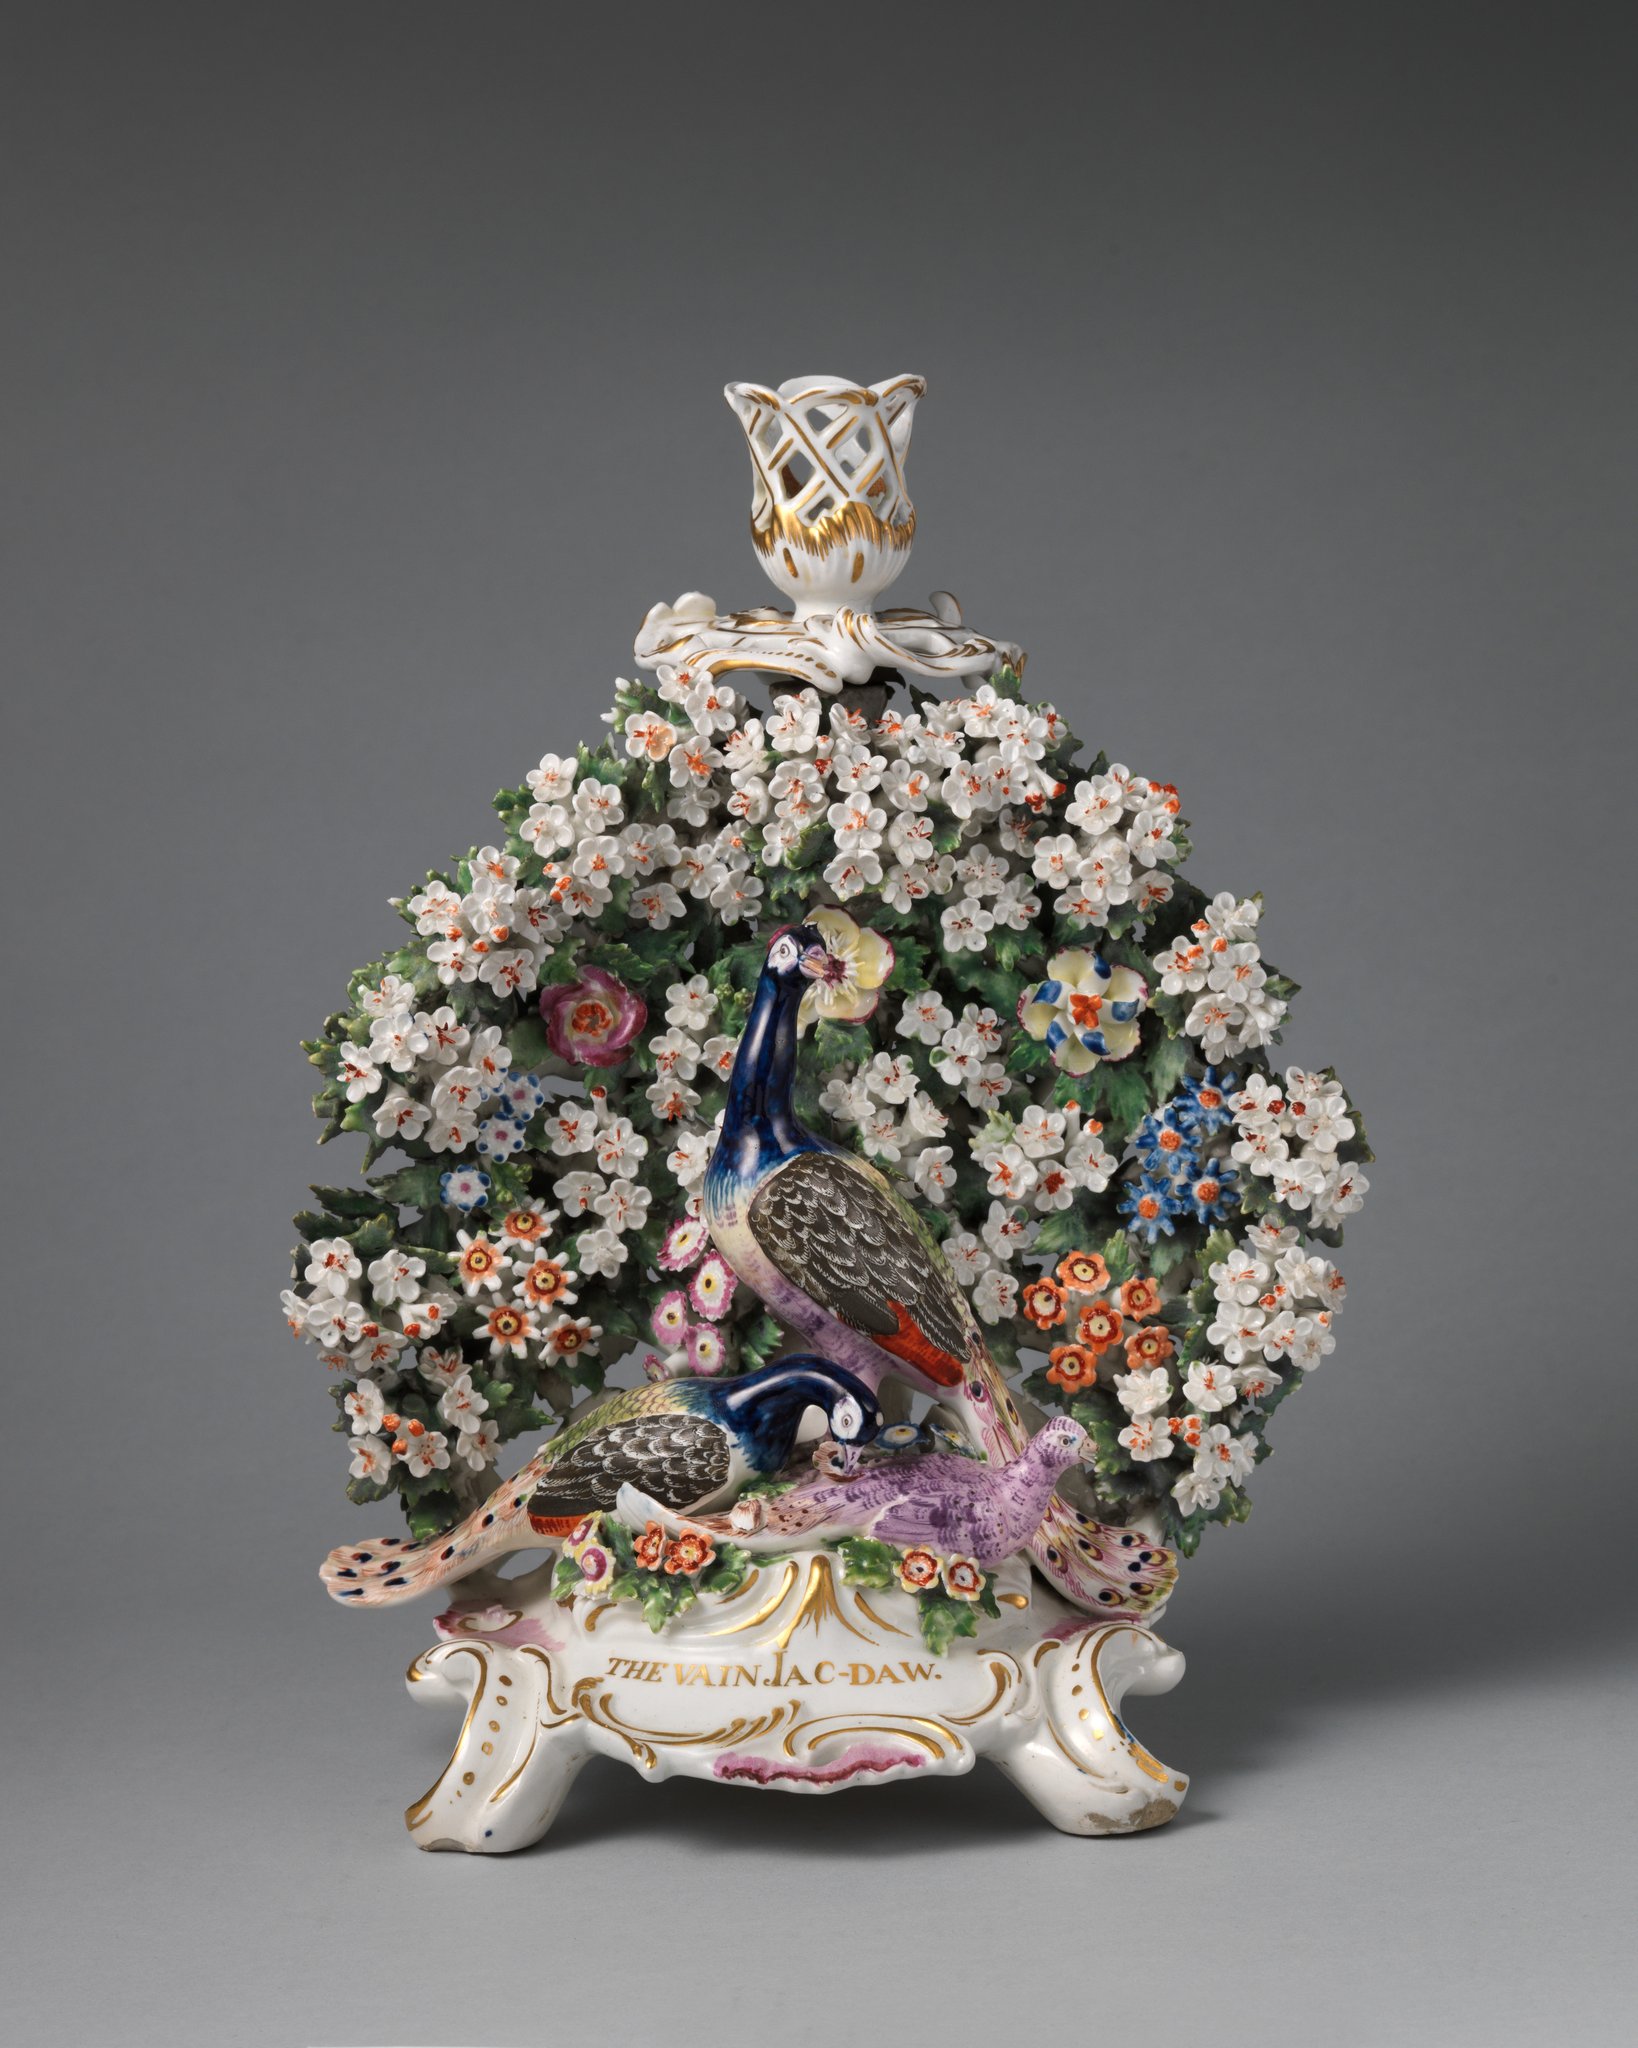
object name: candlestick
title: Candlestick (one of a pair)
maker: derby porcelain manufactory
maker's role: factory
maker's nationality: british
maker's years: 1751-1785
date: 1769-1770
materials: soft paste porcelain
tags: peacocks